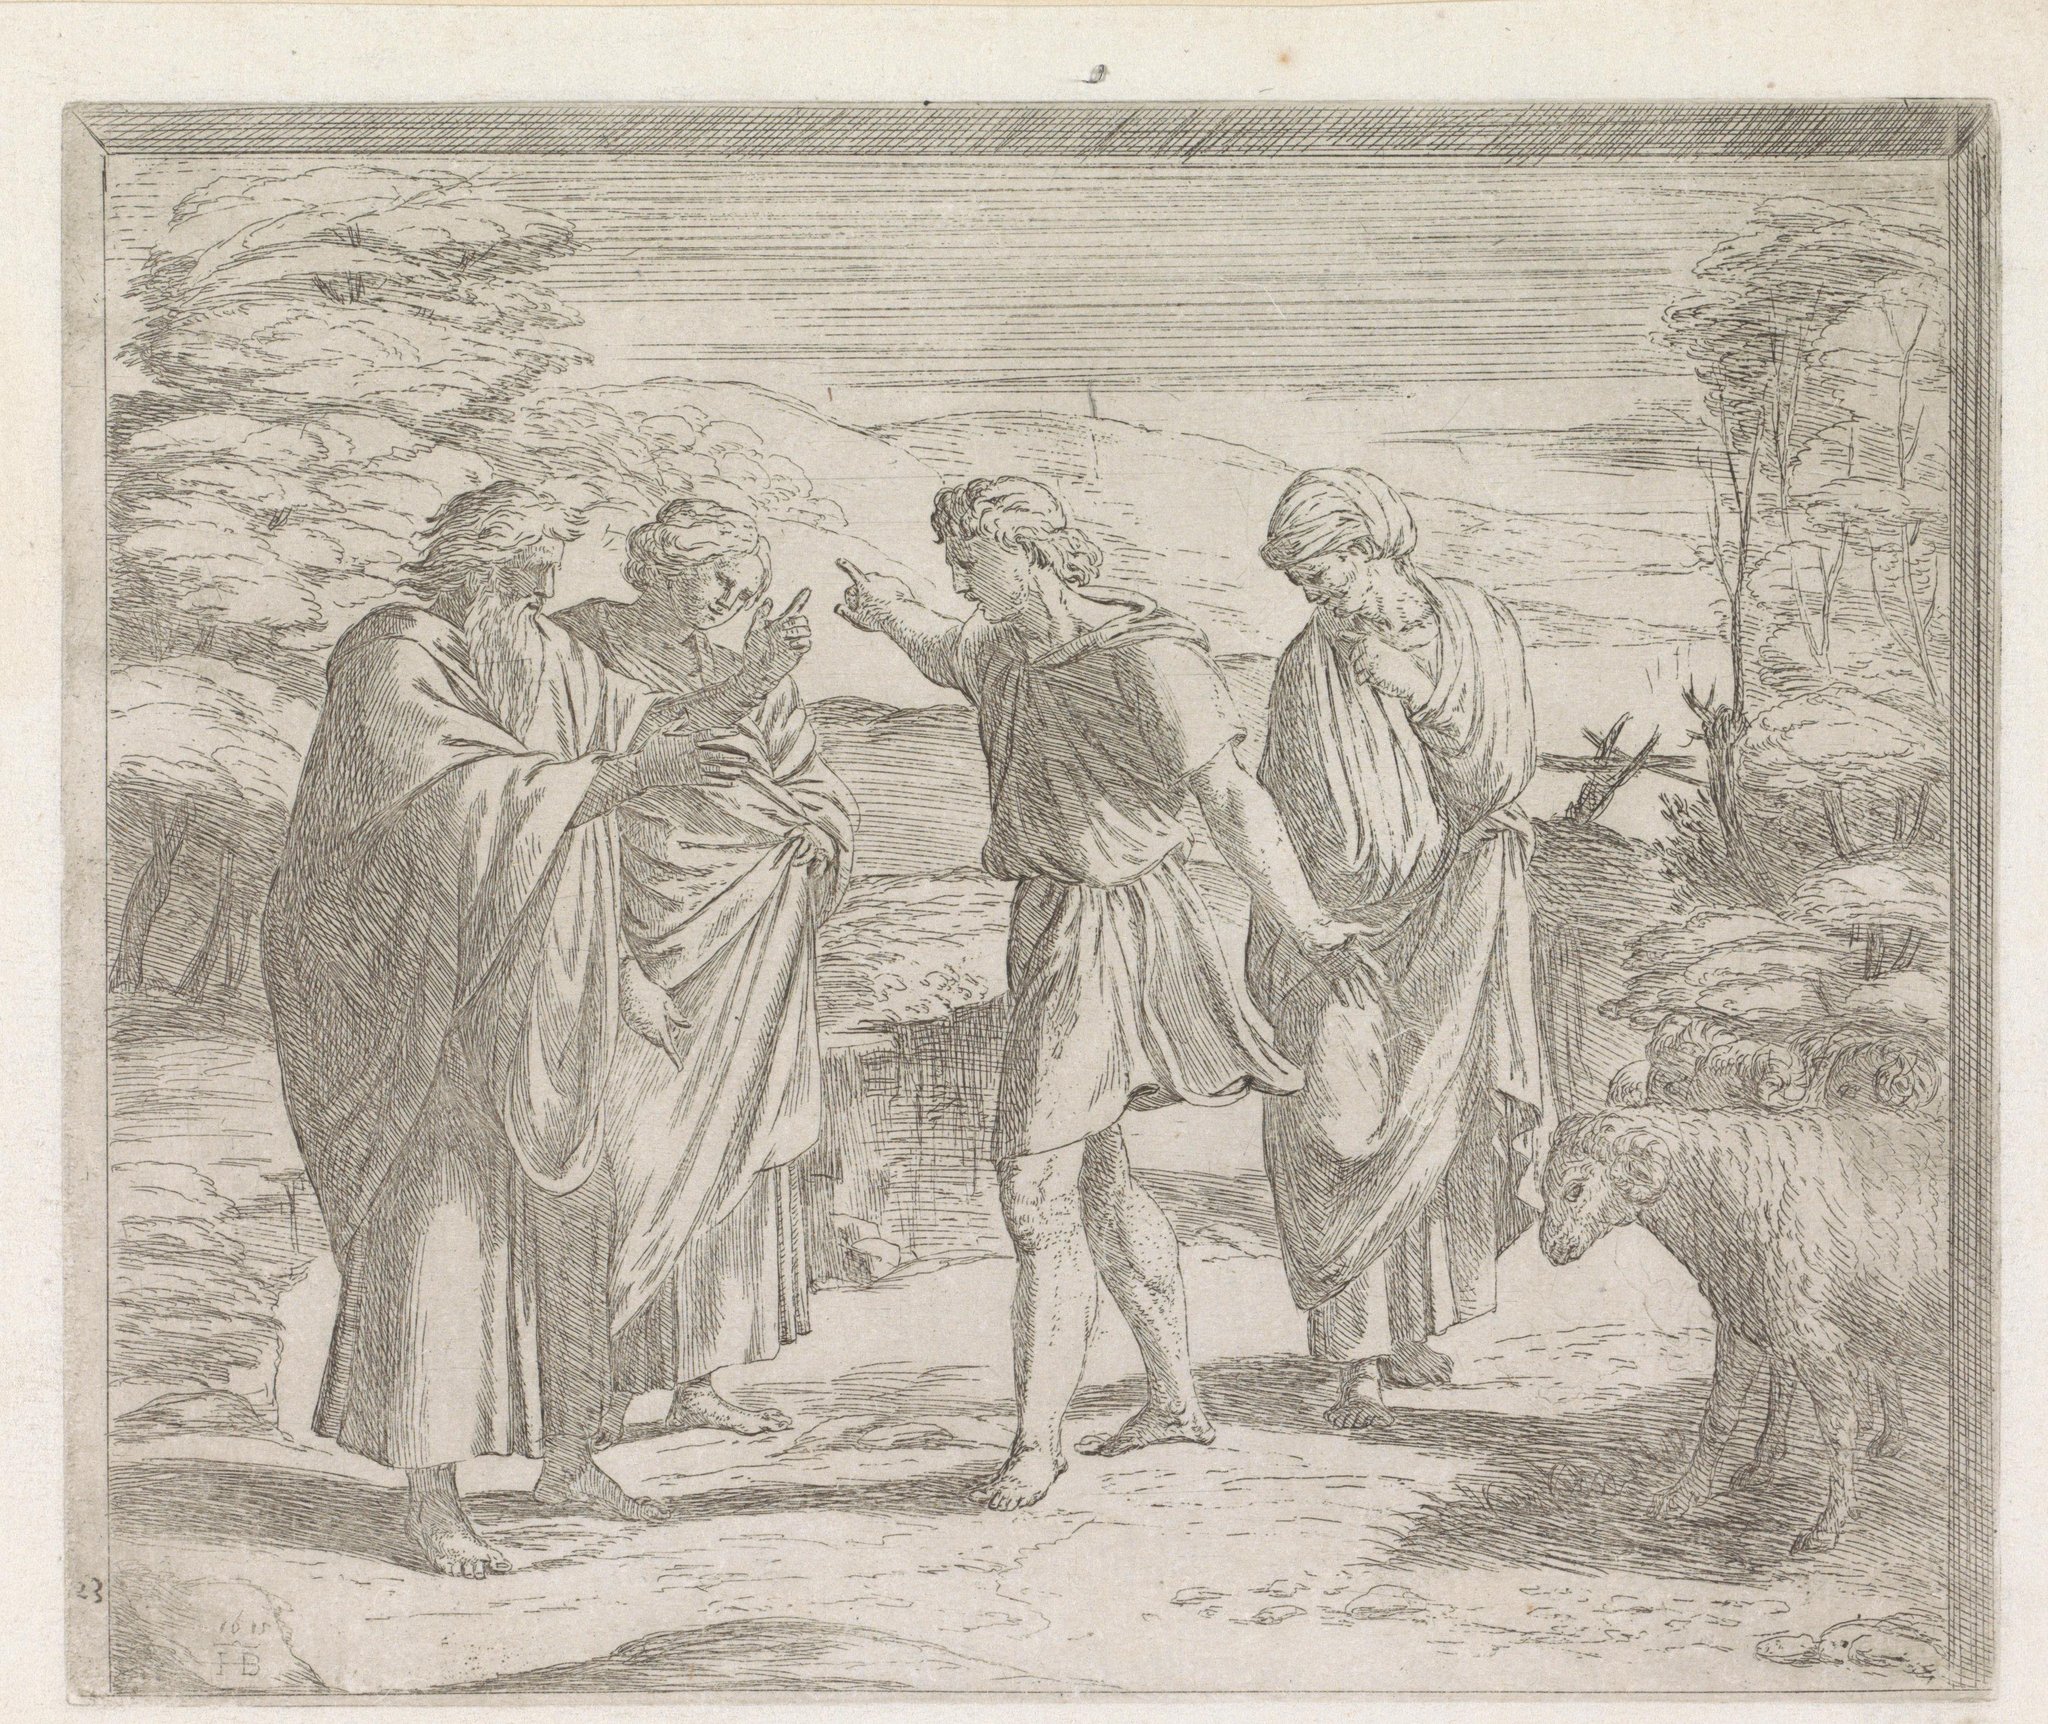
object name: print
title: Schilderingen in de Loggia van Rafaël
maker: orazio borgianni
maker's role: print maker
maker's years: 1578-1616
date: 1615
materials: paper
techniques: etching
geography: vatican city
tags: after the wedding-night jacob discovers that he has been deceived with leah and complains to laban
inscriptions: collector's mark: Lugt 2165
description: Jakob staat voor Laban en beklaagt zich, in het bijzijn van Lea en Rachel, over de list van Laban. Laban bedroog Jakob door hem in plaats van met Rachel met Lea te laten trouwen.